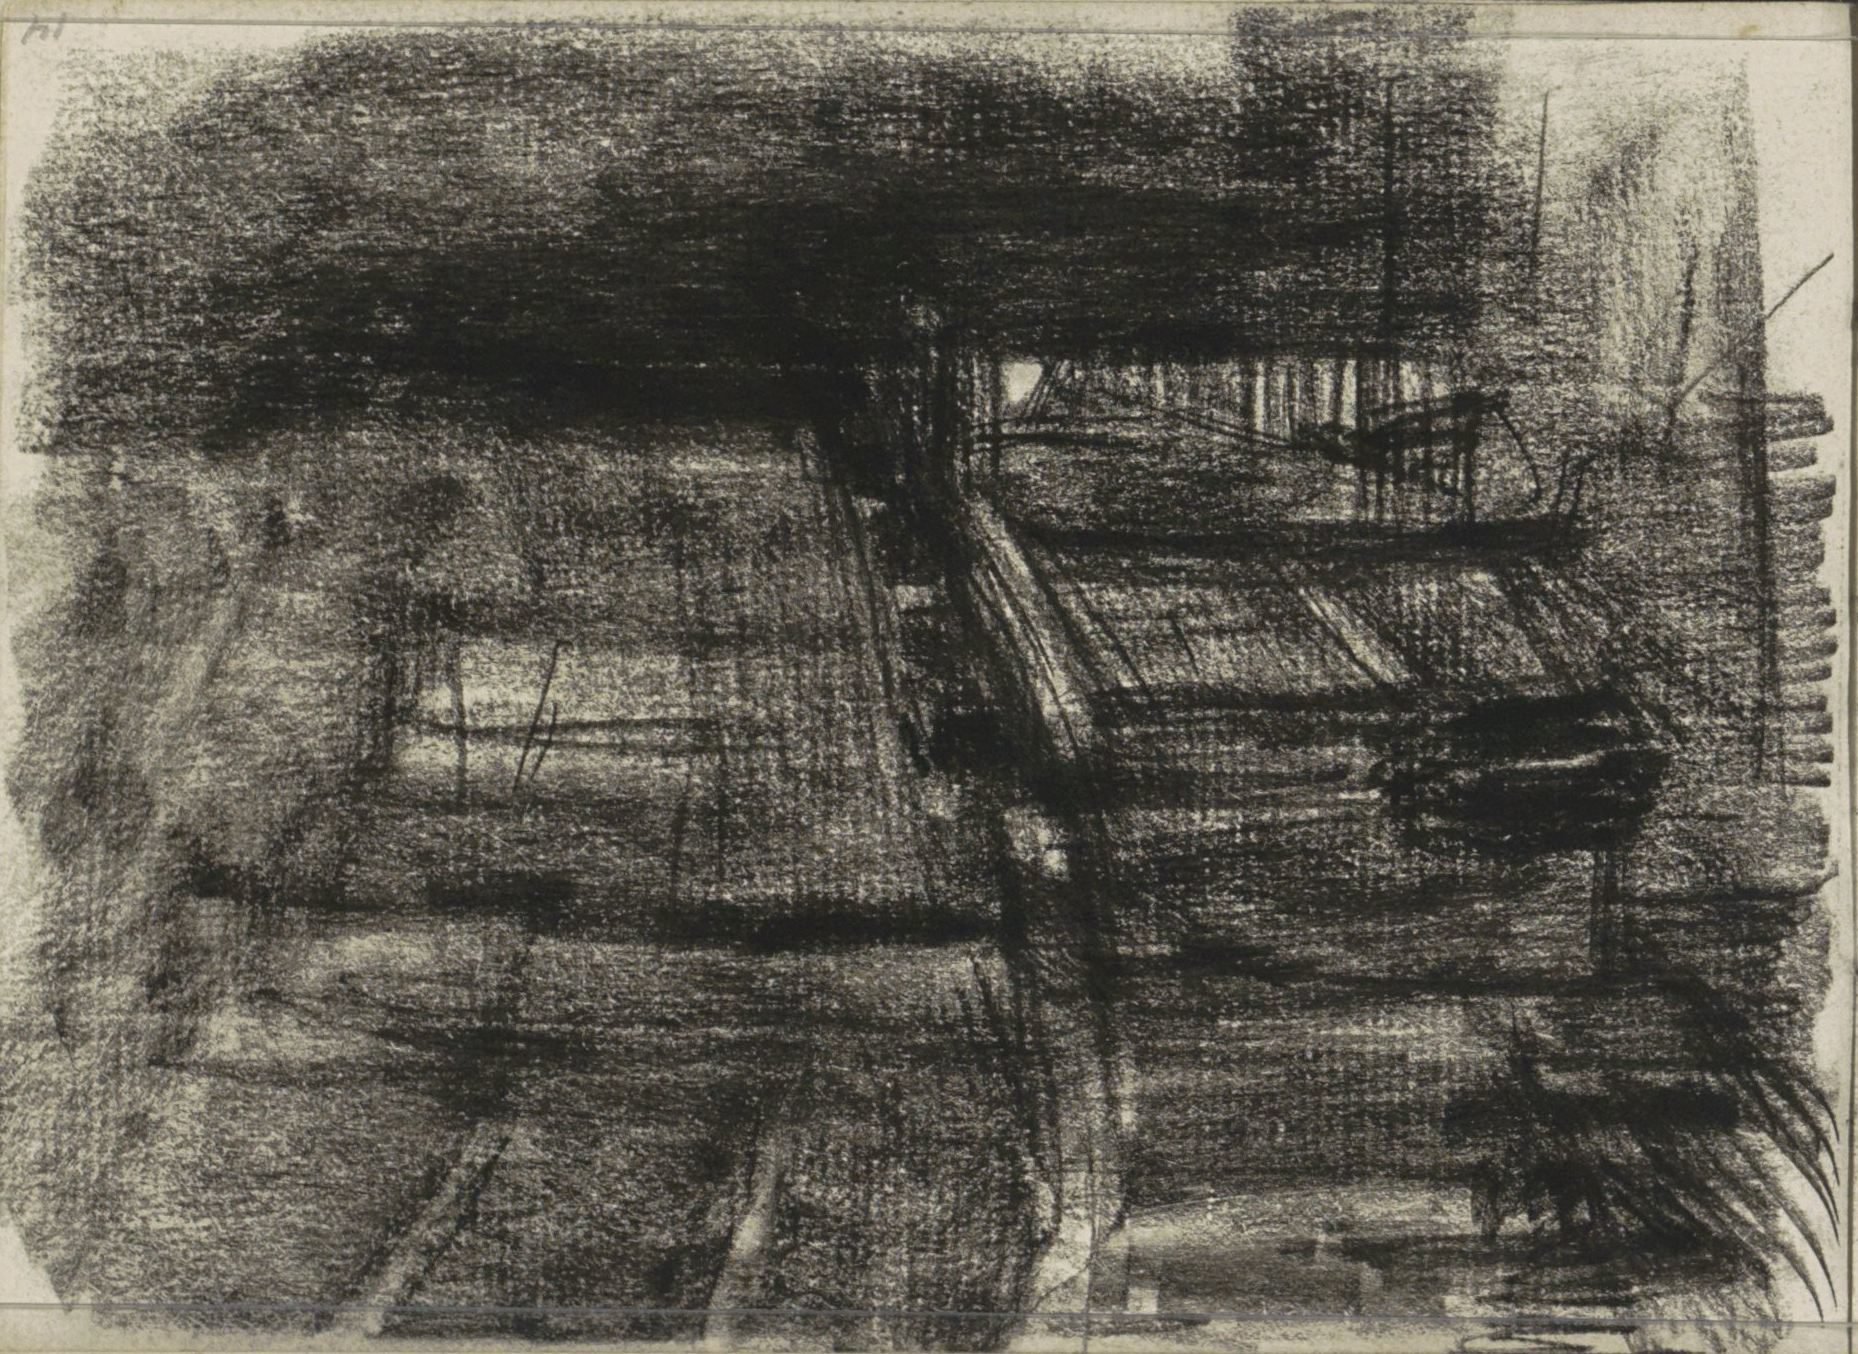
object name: sketchbook leaf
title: Gebouwen, mogelijk winkelpuien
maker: isaac israels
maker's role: draughtsman, painter, print maker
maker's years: 1865-1934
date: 1875-1934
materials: chalk, paper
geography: amsterdam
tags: civic architecture; edifices; dwellings, shop-window, show-window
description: Voor de gebouwen staan figuren. Blad 7 verso uit schetsboek XXXI met 10 bladen.